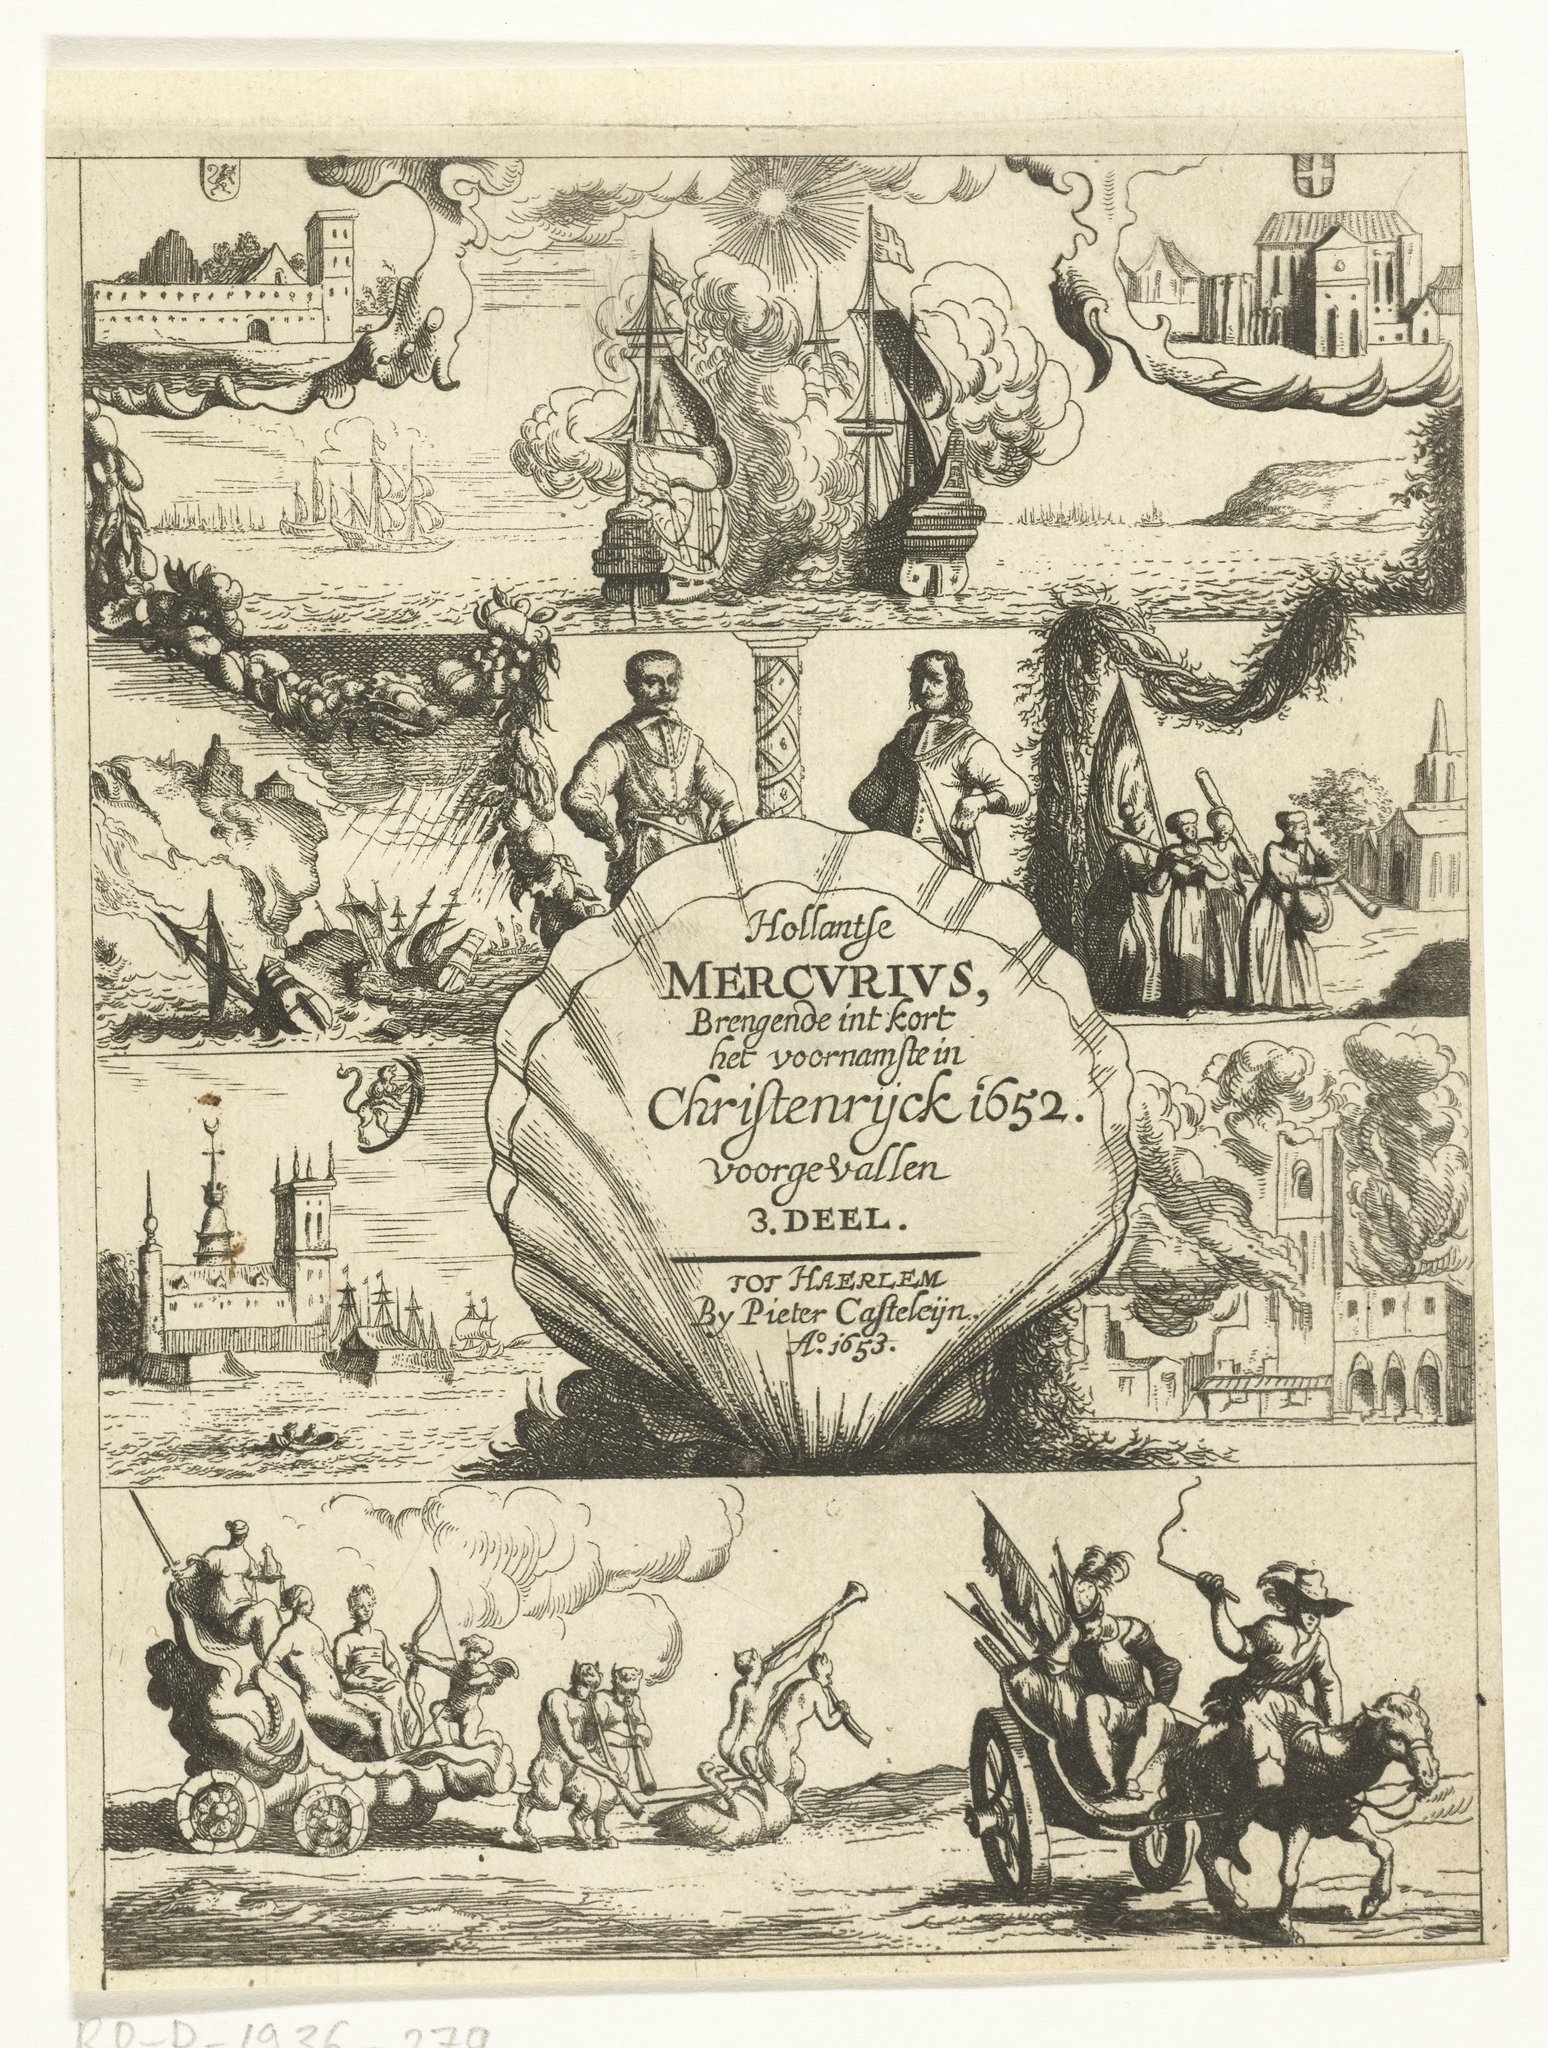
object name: print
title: Titelpagina voor: Hollantse Mercurius, 1652, deel 3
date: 1653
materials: paper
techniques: etching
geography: haarlem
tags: warfare; military affairs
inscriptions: collector's mark: Lugt 2228, collector's mark: Lugt 2760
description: Titelpagina voor: Hollantsche Mercurius, brengende 't verhael der gewichtichste veranderingen, voor-gevallen in Europa, binnen den tijt van het geheele jaer 1652, deel 3, Haarlem, uitgever Pieter Casteleyn, 1653. Bij FMH 1980 staat dat het om de titelbladen voor jaren 1650, 51 en 54 gaat. Het zijn echter de titelbladen voor de jaren 1651, 1652 en 1654.